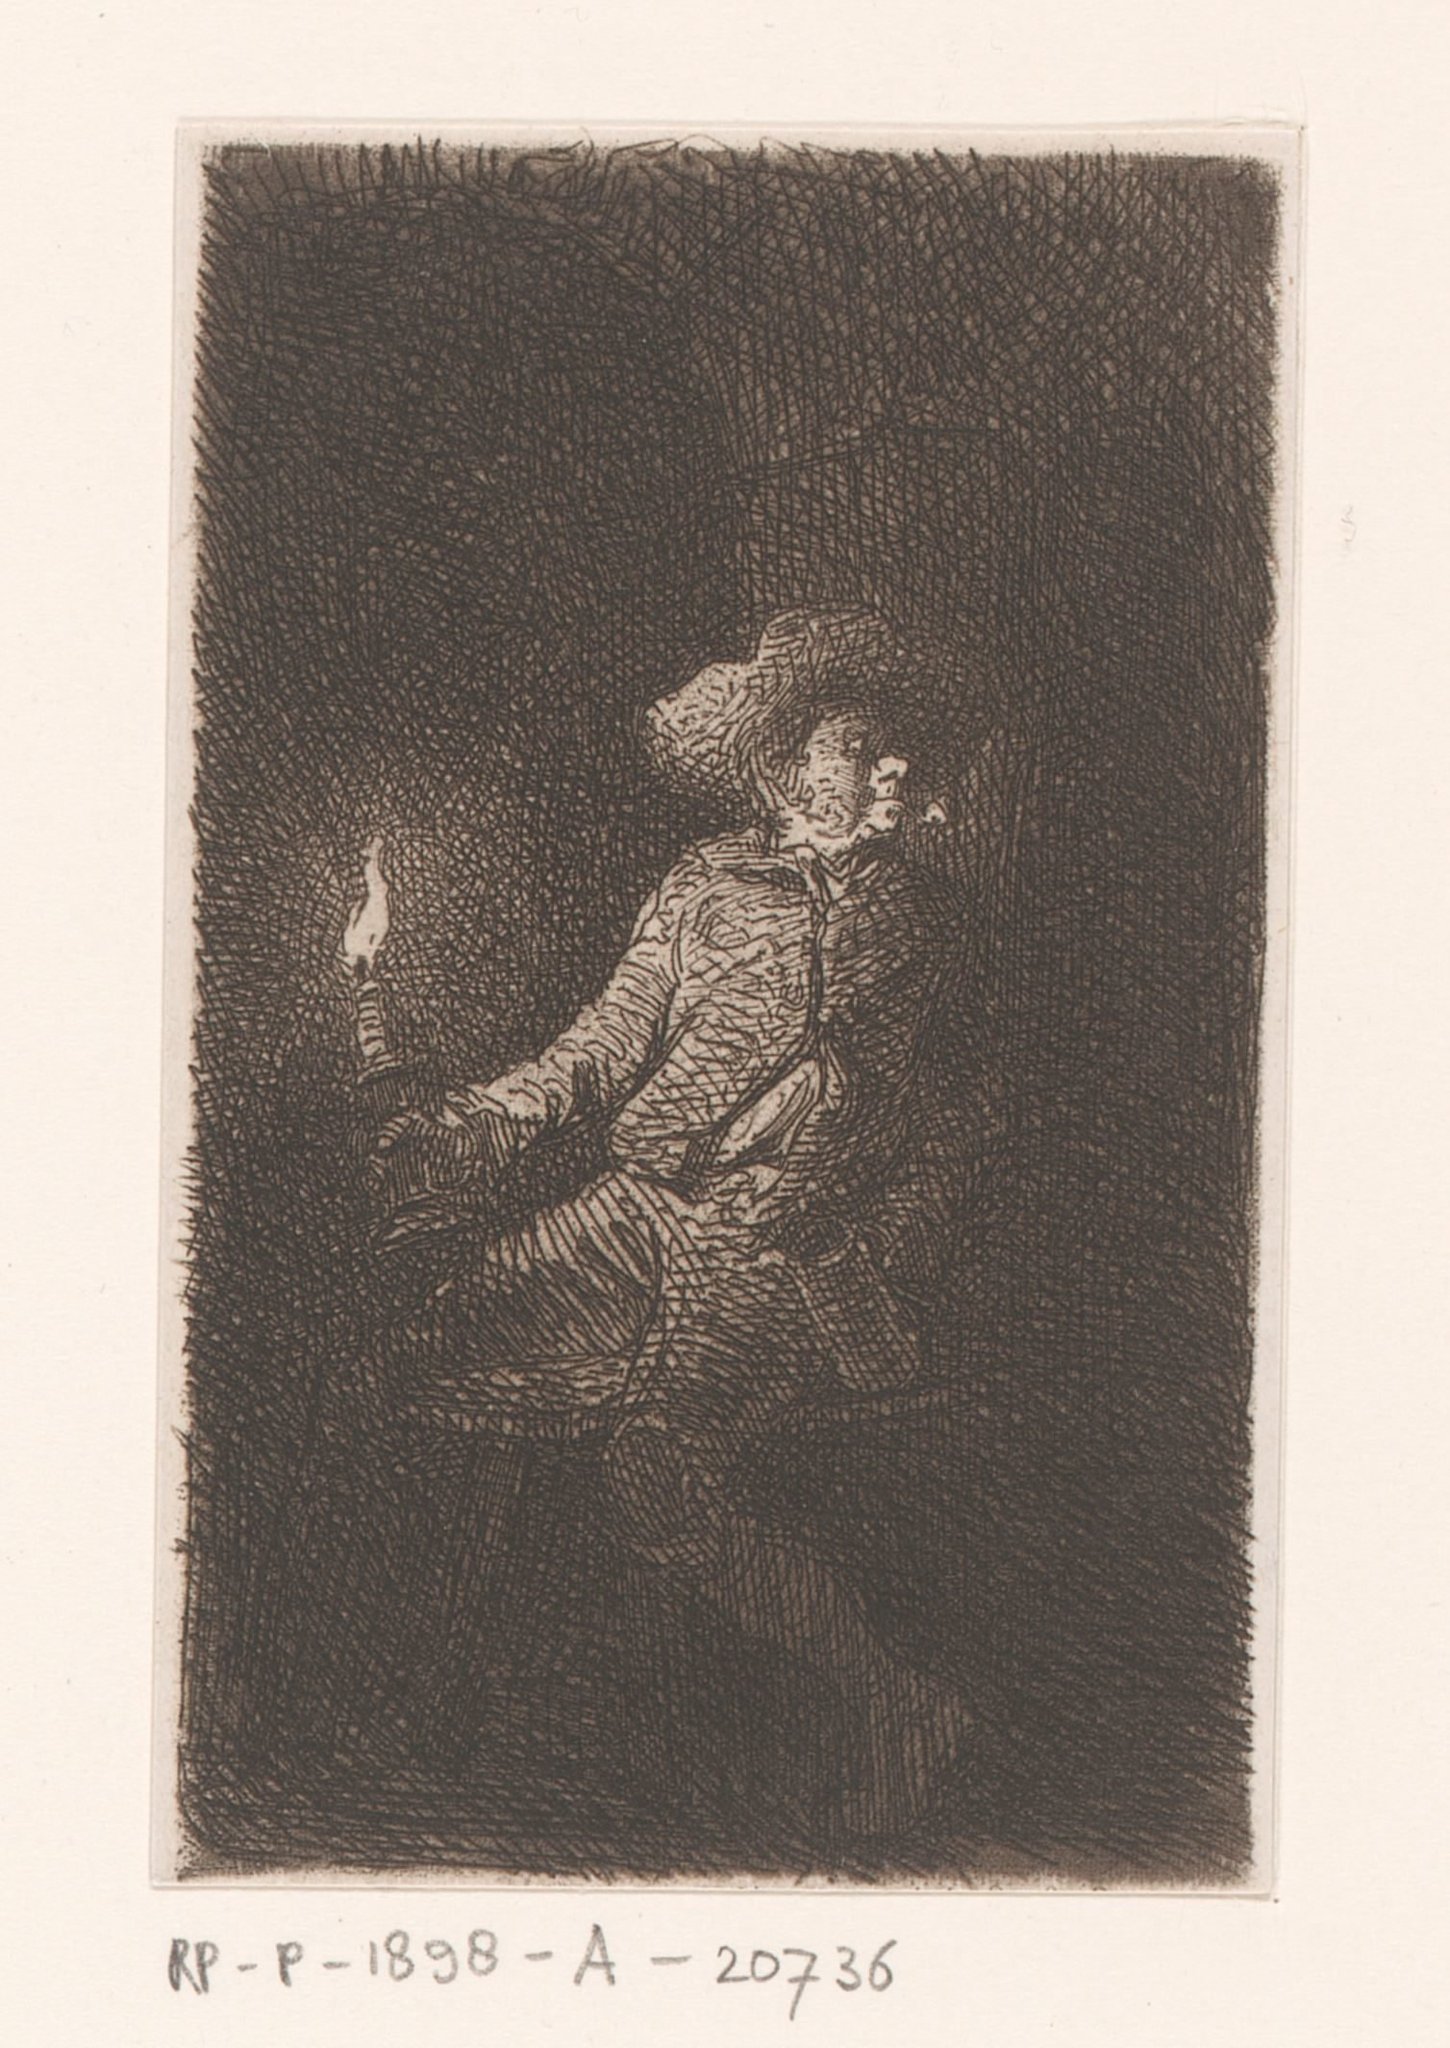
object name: print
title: Rokende man in kelder bij kaarslicht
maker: charles emile jacque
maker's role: draughtsman, painter, print maker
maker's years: 1813-1894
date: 1842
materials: paper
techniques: etching, roulette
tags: pipe ~ tobacco, candlestick, basement, cellar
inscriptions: collector's mark: Lugt 964